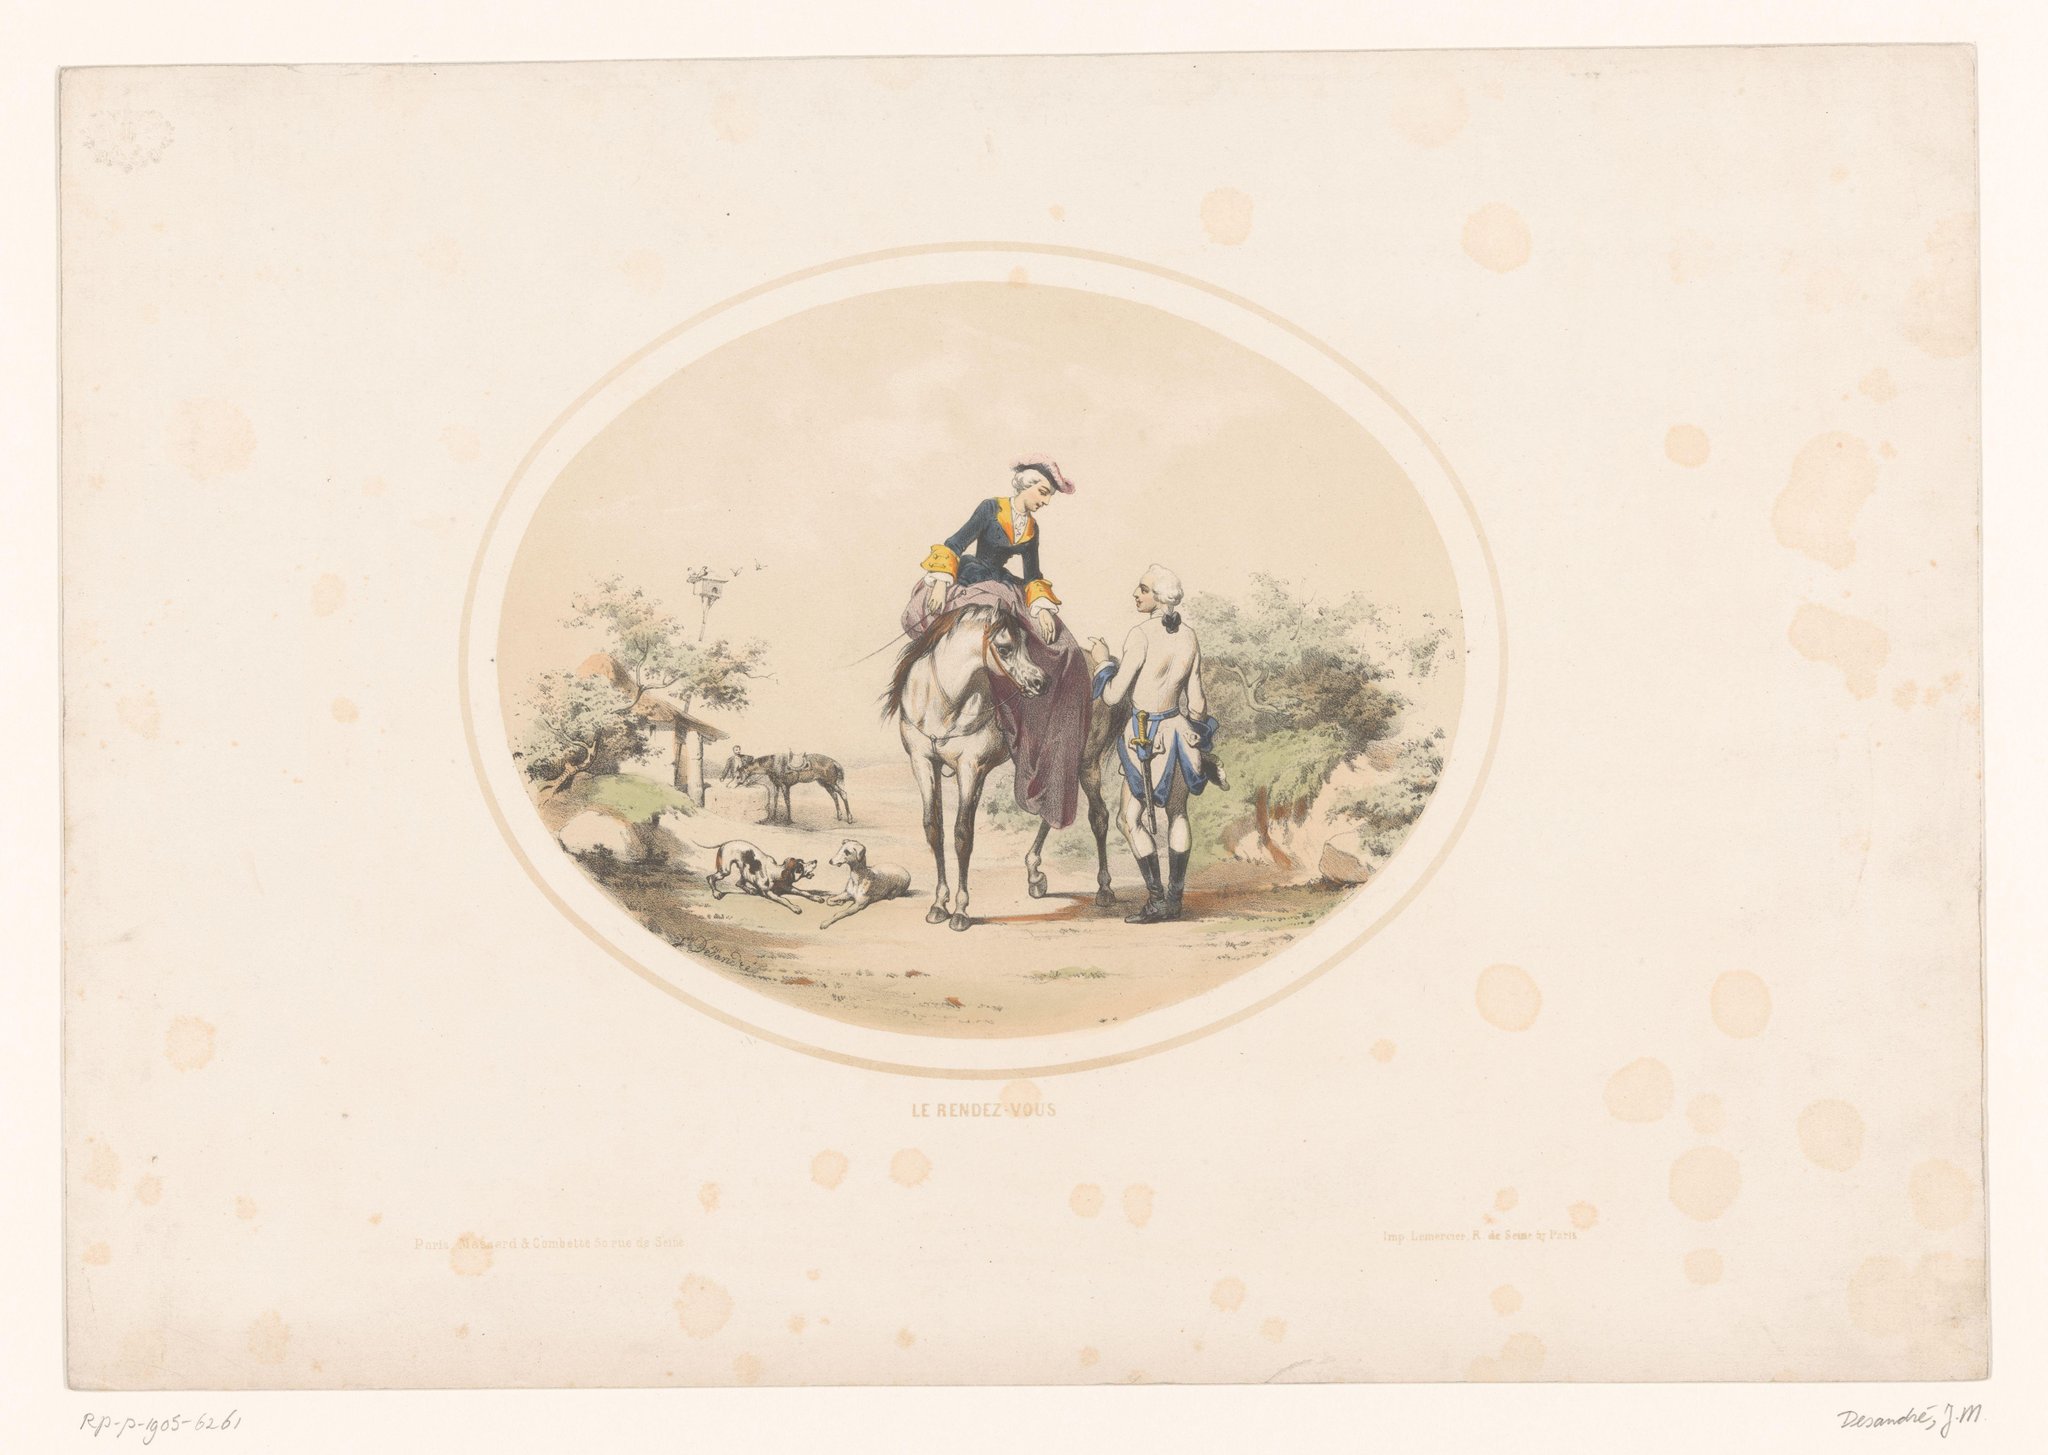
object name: print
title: Le rendez-vous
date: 1840-1870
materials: paper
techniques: hand coloring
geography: paris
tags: riding a horse, ass, or mule; rider, horseman, hunting-seat, hunting lodge, 'rendez-vous de chasse', 'jagdschloss' - cc - female hunter, huntress, lovers' meeting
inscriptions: collector's mark: Lugt 2228a, check stamp: ‘JGB (?)’